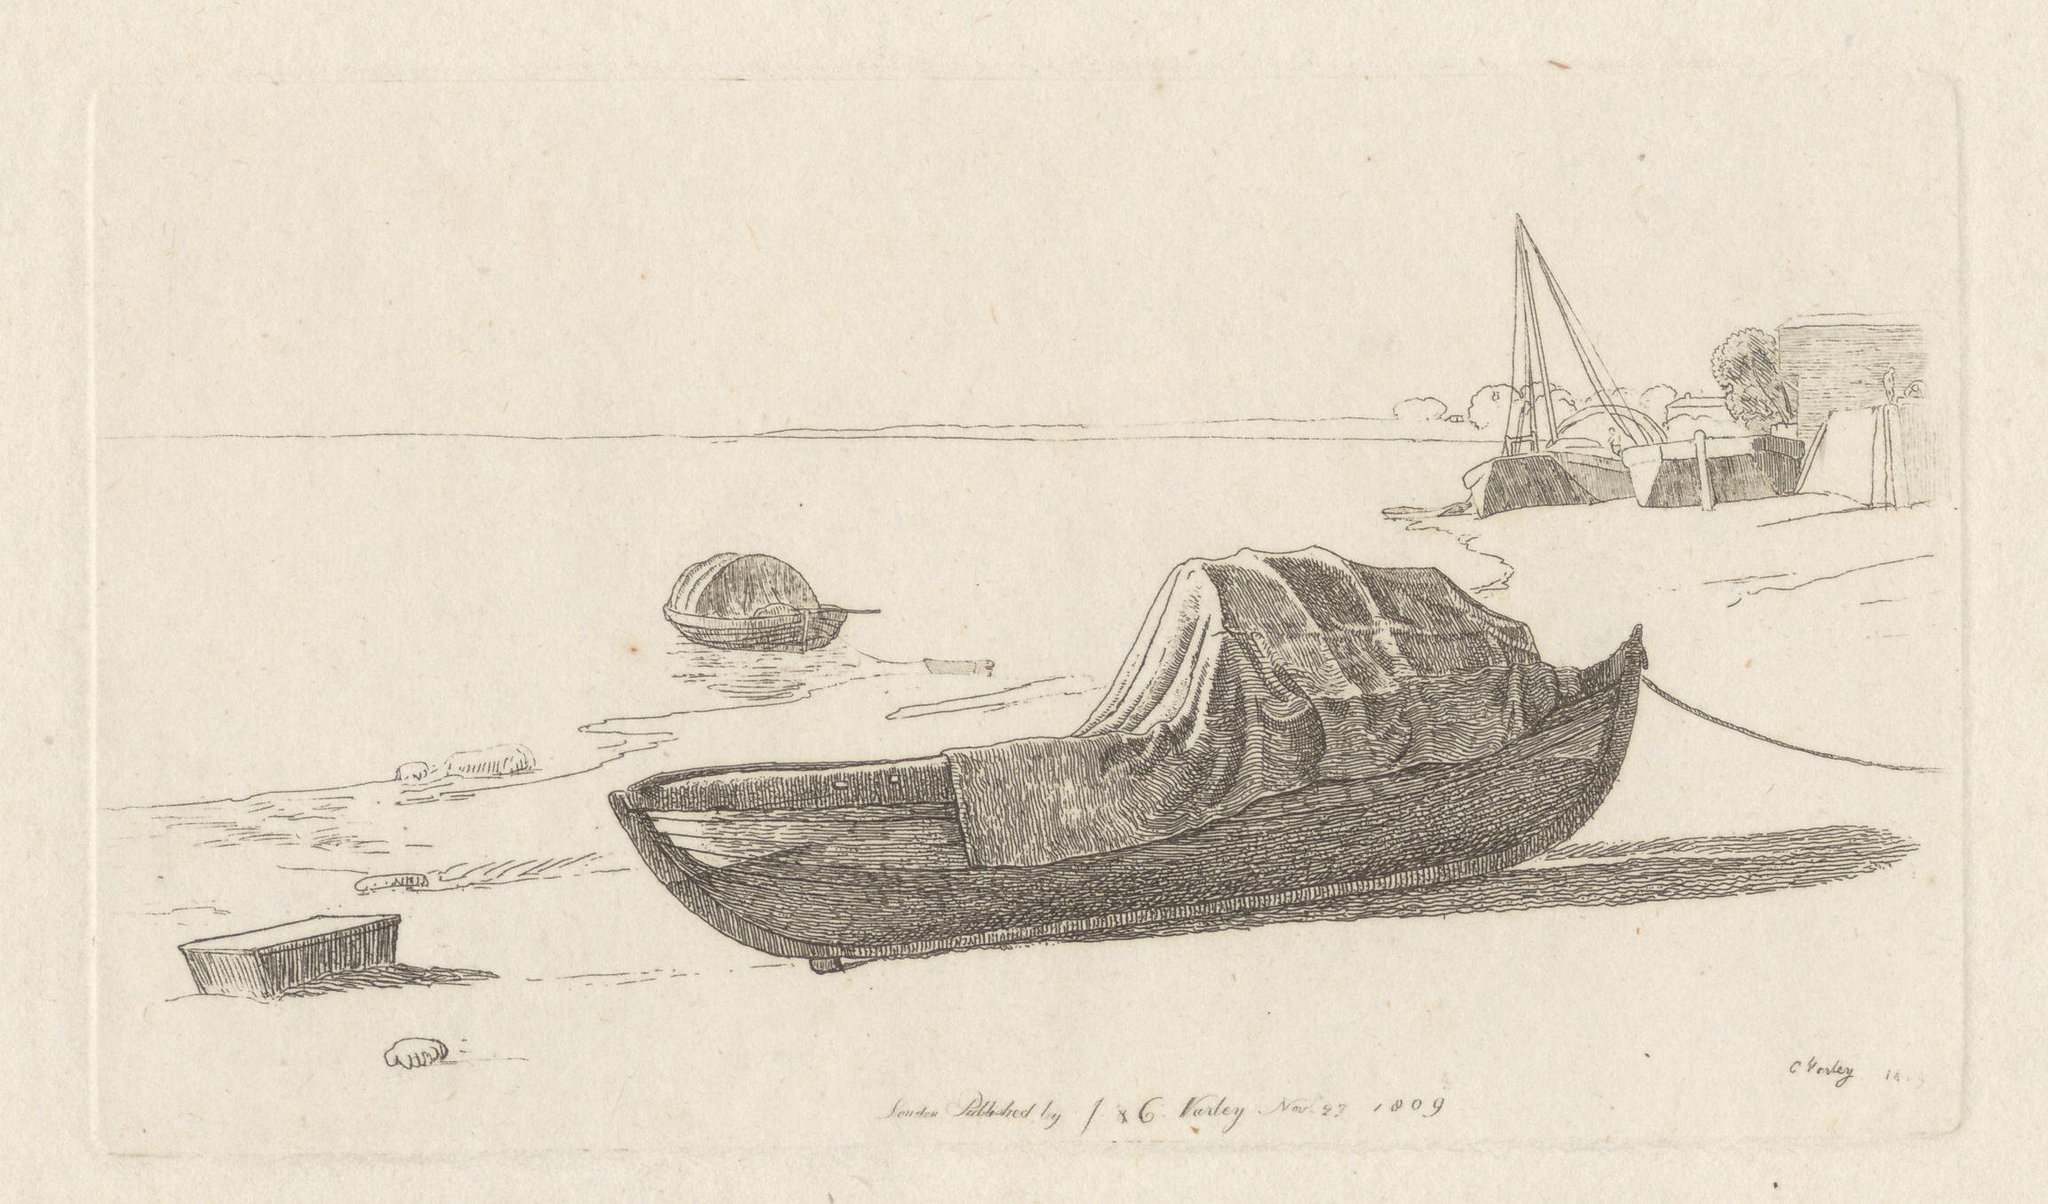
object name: print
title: Etsen van de Scheepvaart, Binnenvaartschepen, Vissersboten en andere Schepen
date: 1809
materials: paper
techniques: etching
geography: london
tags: rowing-boat, canoe, etc., harbour (+ number of persons ~ traffic and transport), thames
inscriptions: collector's mark: Lugt 2228, collector's mark: Lugt 2760